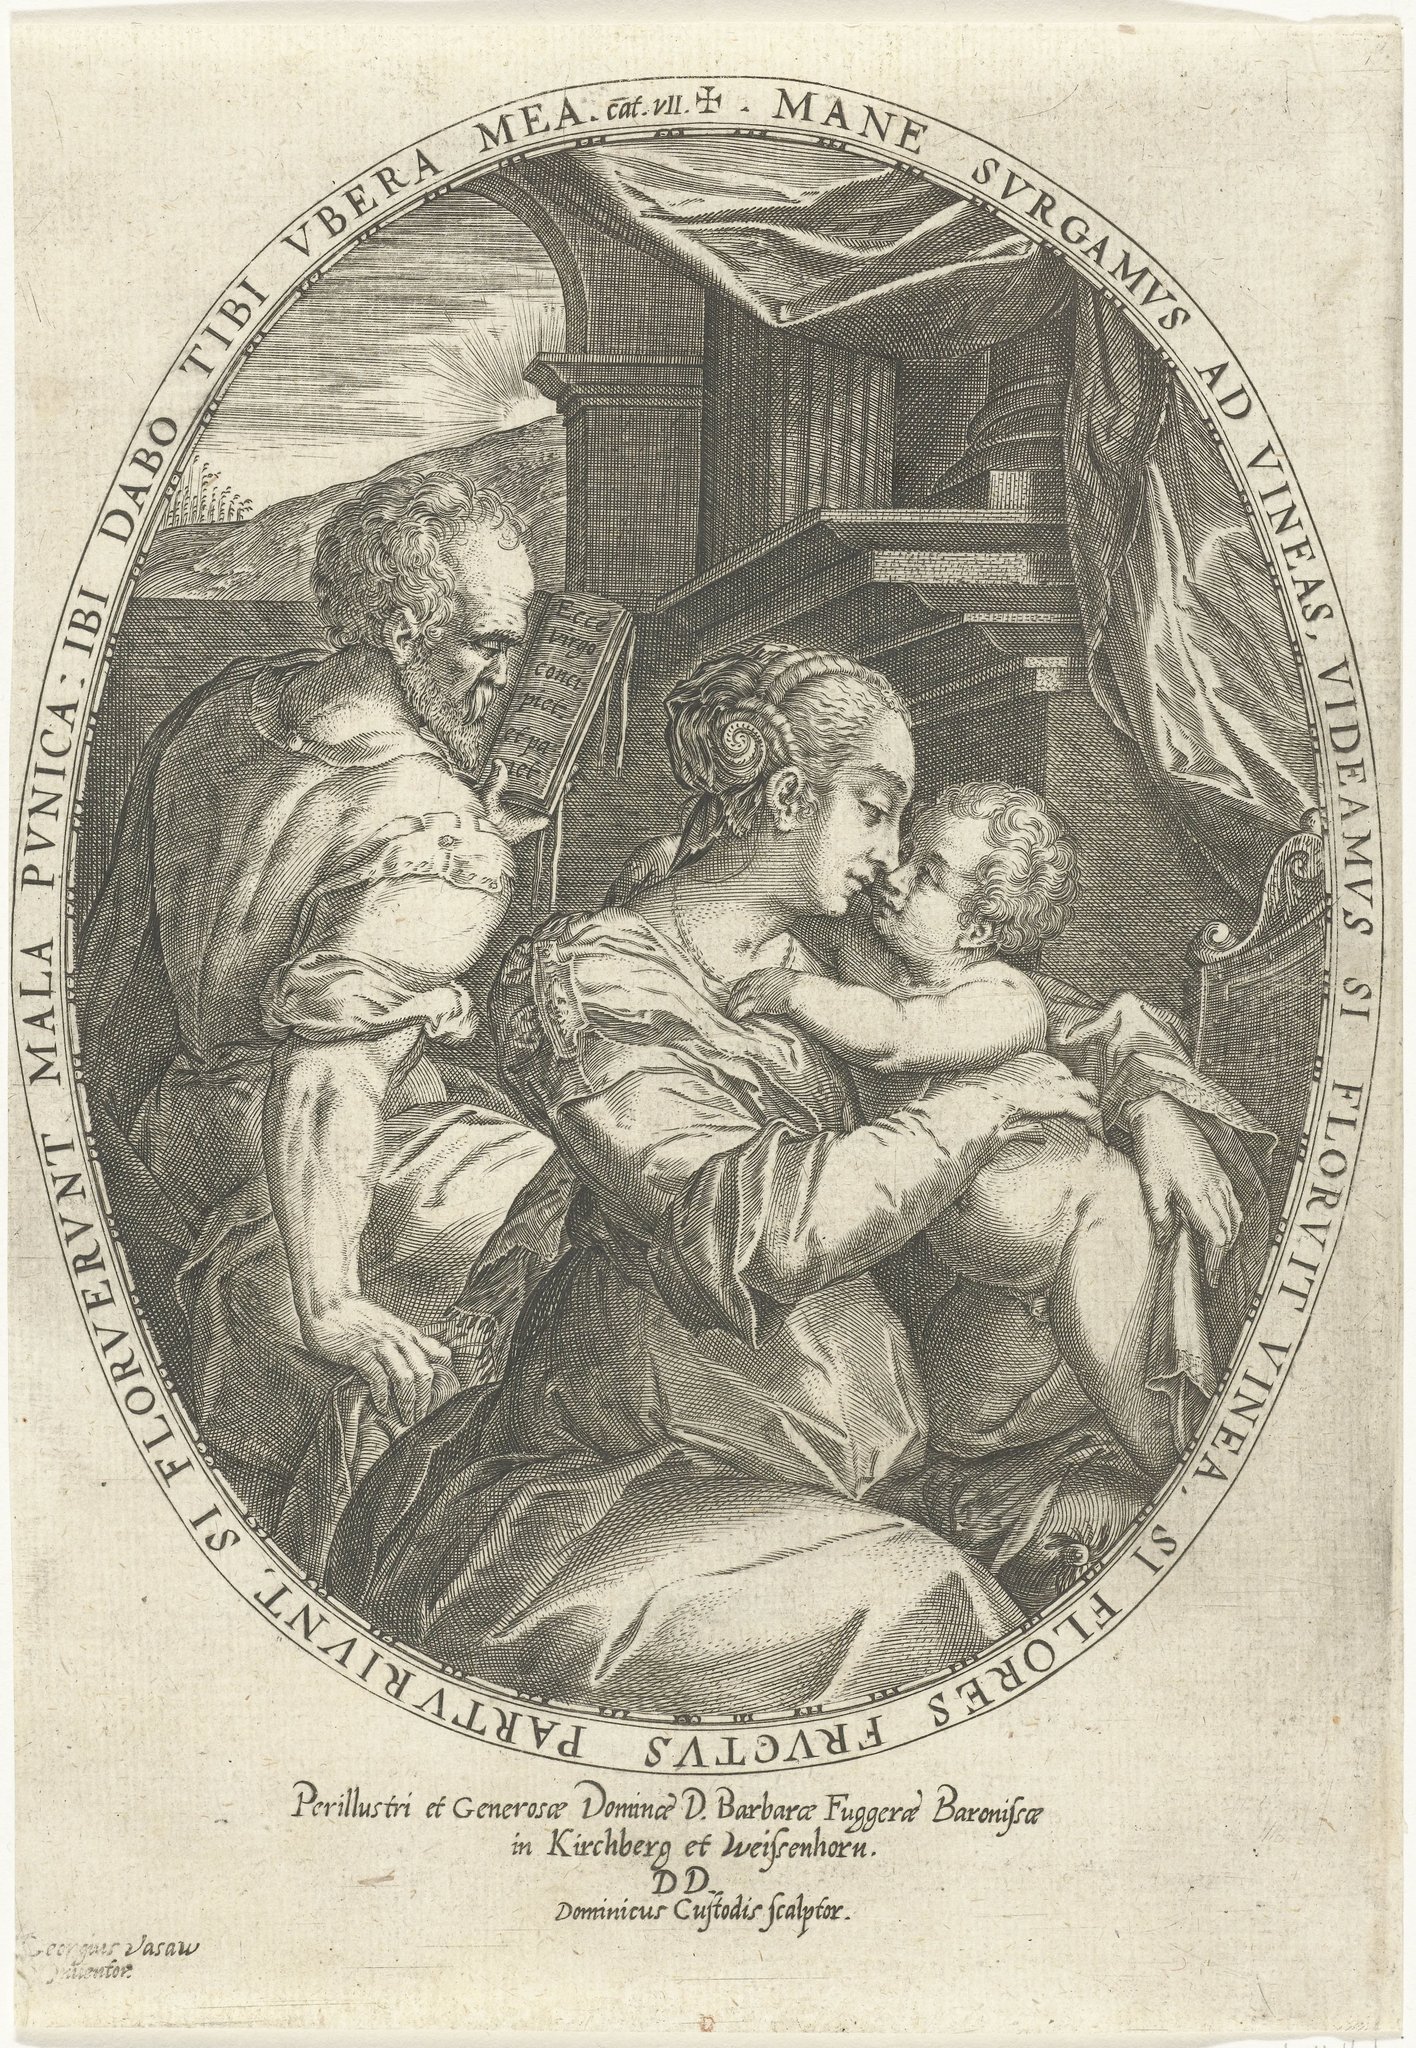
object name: print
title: Heilige Familie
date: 1579-1615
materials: paper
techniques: engraving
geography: augsburg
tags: holy family, and derived representations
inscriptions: collector's mark: Lugt 2228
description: Maria zit op een stoel, het Kind knielt in haar schoot en speelt met haar halsketting. Jozef zit schuin achter Maria en leest in een boek. Voorstelling in ovaal met Latijns randschrift.